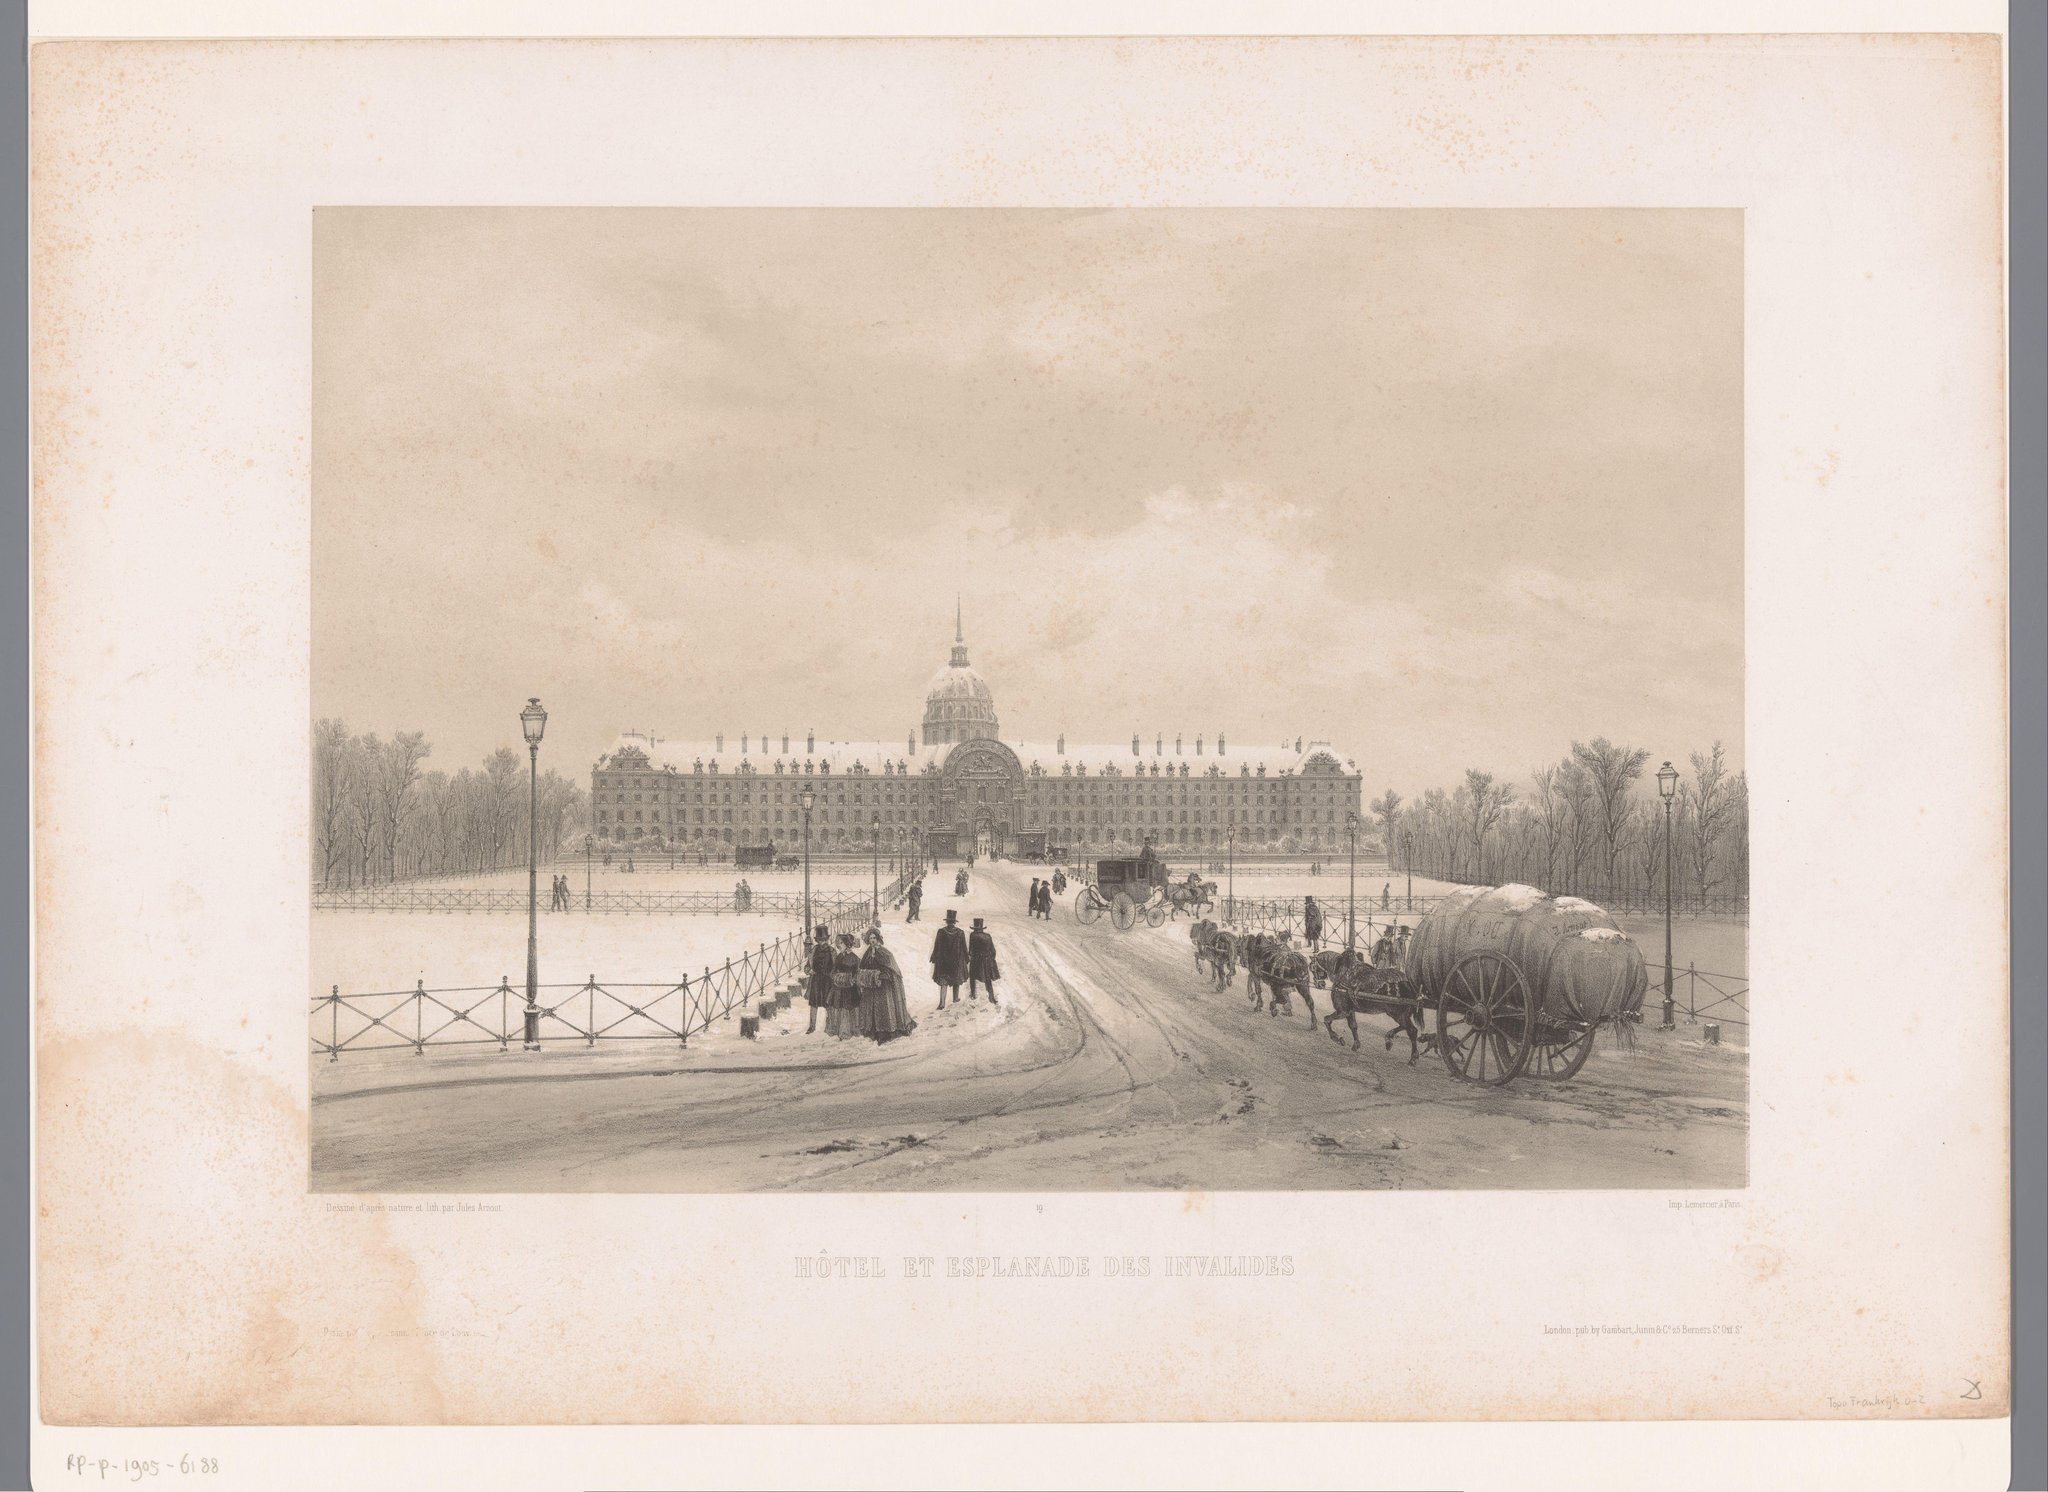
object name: print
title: Hötel et Esplanade des Invalides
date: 1844-1845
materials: paper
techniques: tone lithography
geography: london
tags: avenue, boulevard, promenade, esplanade, old-soldiers-home, 'hôtel des invalides', dome ~ architecture, paris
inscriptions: collector's mark: Lugt 2228, check stamp: Lugt 4964, workshop stamp: ‘J.A.’